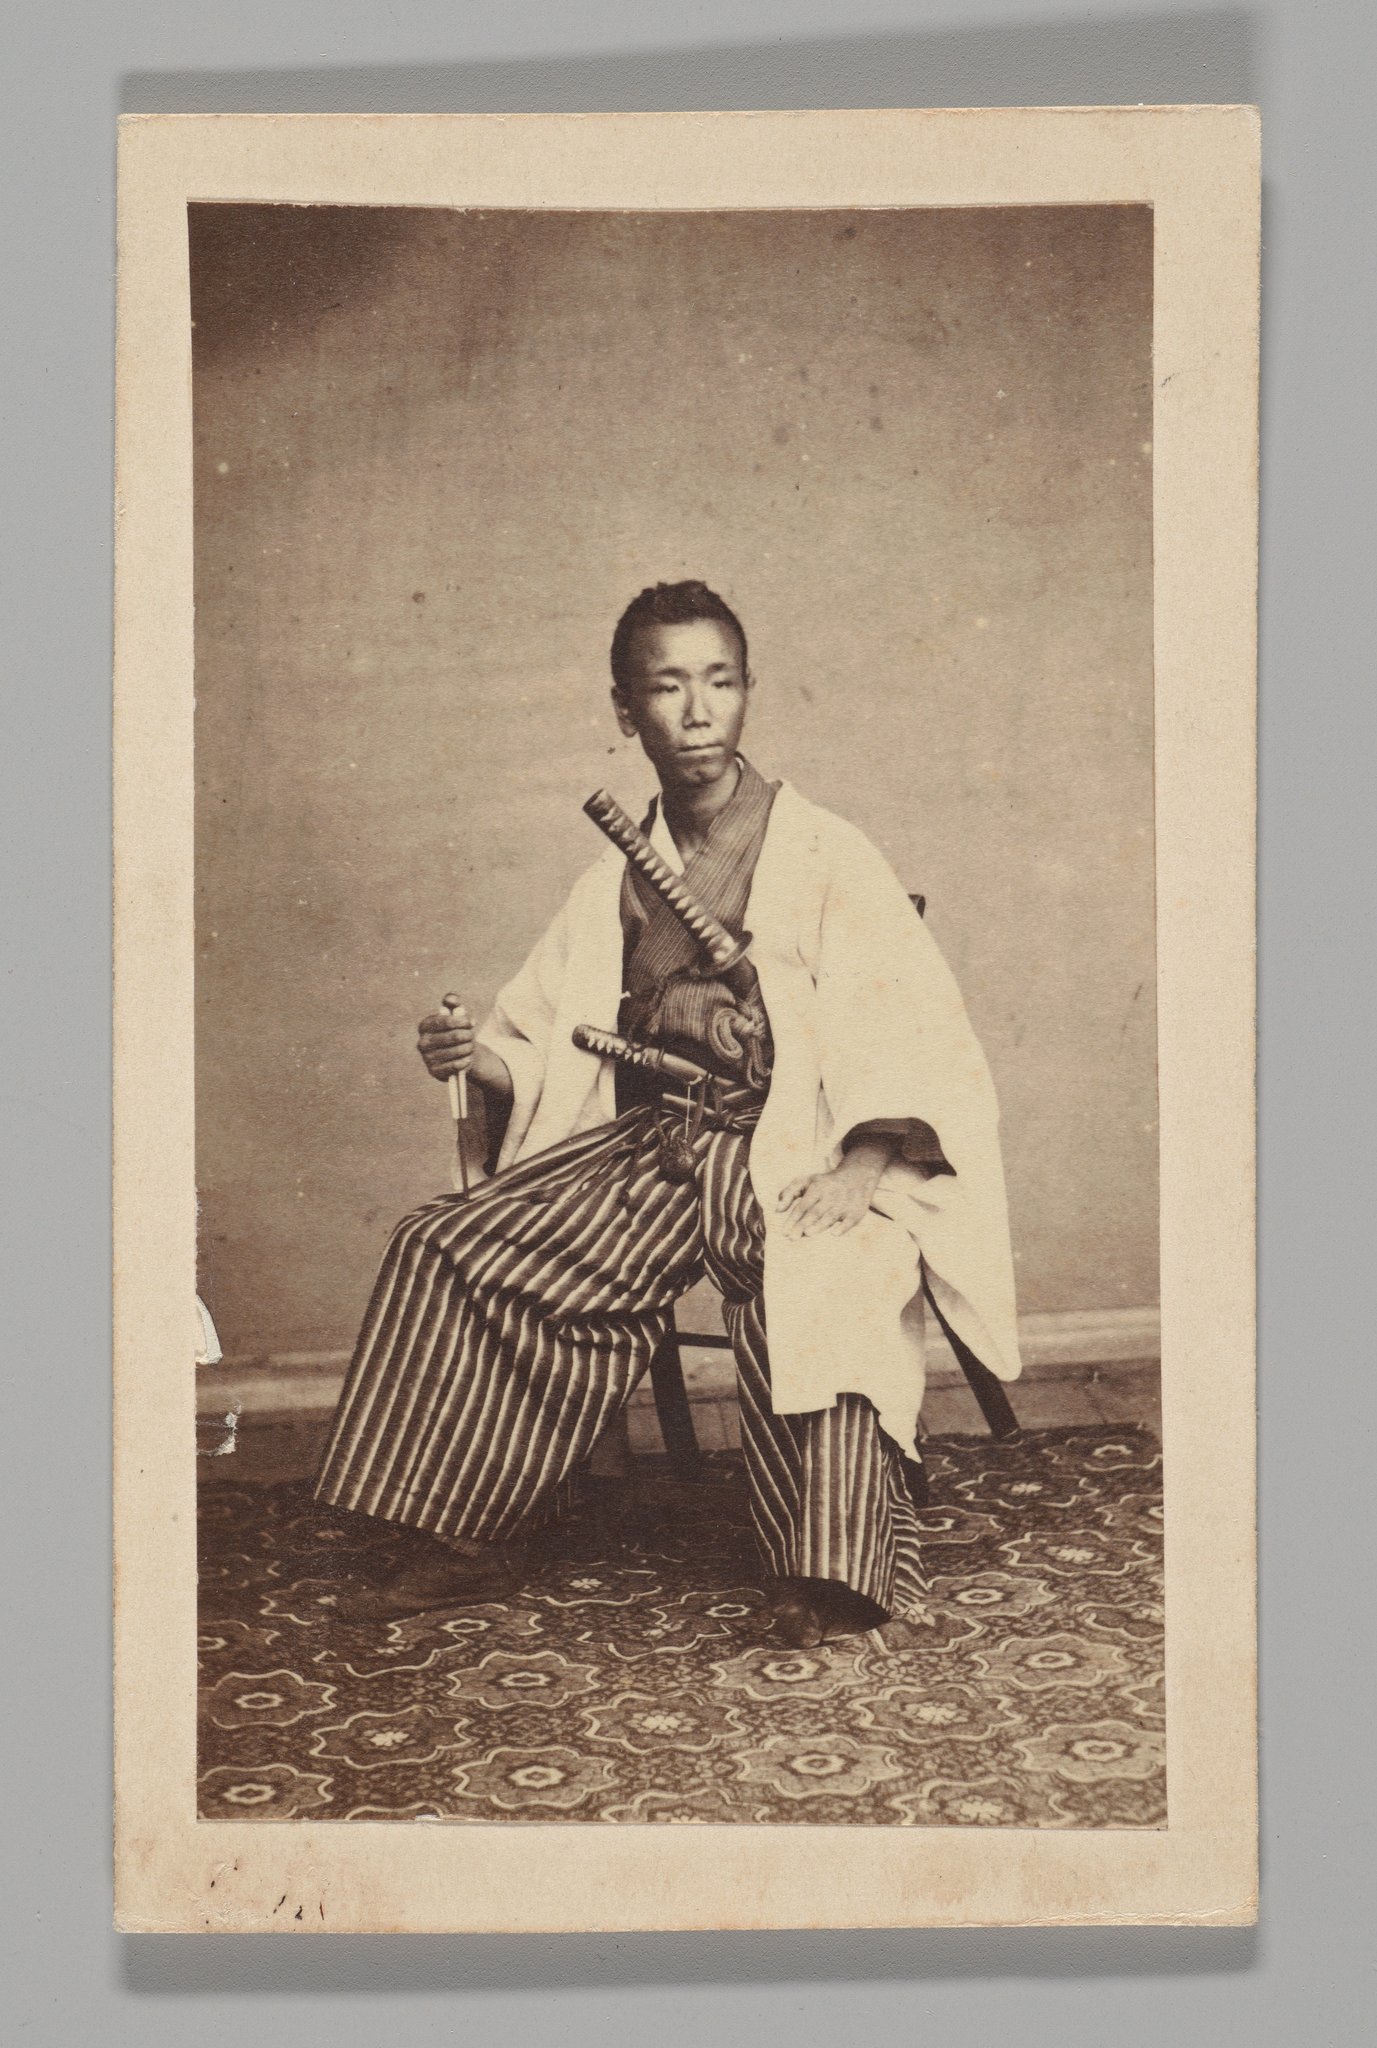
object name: carte de visite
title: [Studio Portrait: Man Seated with Swords]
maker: Anonymous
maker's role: artist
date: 1869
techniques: albumen silver print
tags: men,portraits